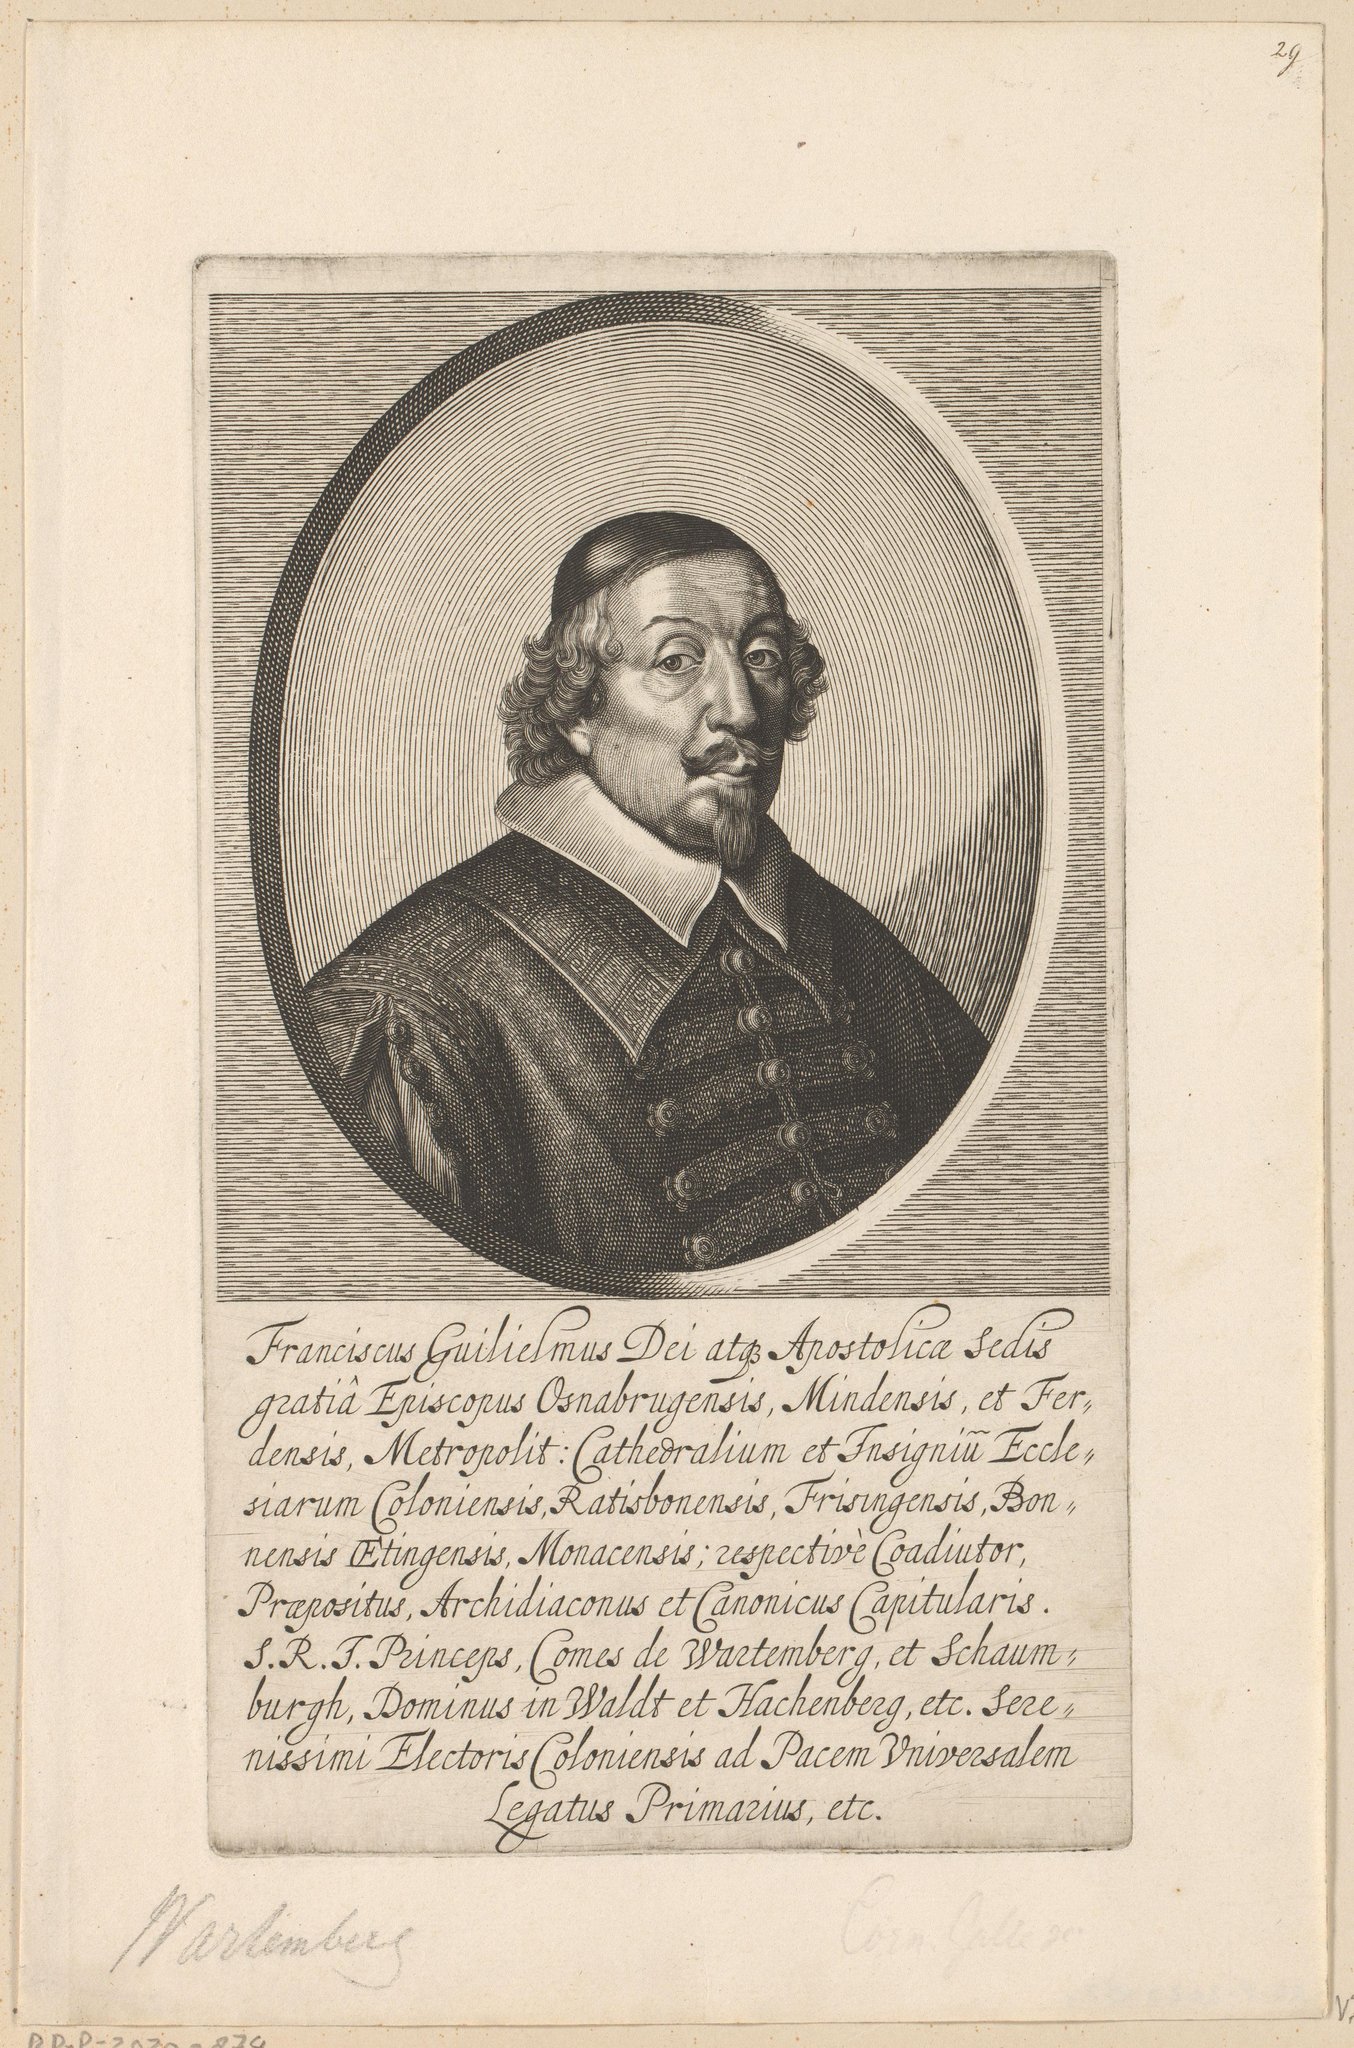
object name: print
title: Portret van Franz Wilhelm van Osnabrück, graaf van Wartenberg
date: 1644-1671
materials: paper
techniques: engraving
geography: amsterdam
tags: priest, archbishop, bishop, etc. (roman catholic), historical persons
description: Prent maakt deel uit van een serie van 43 prenten.